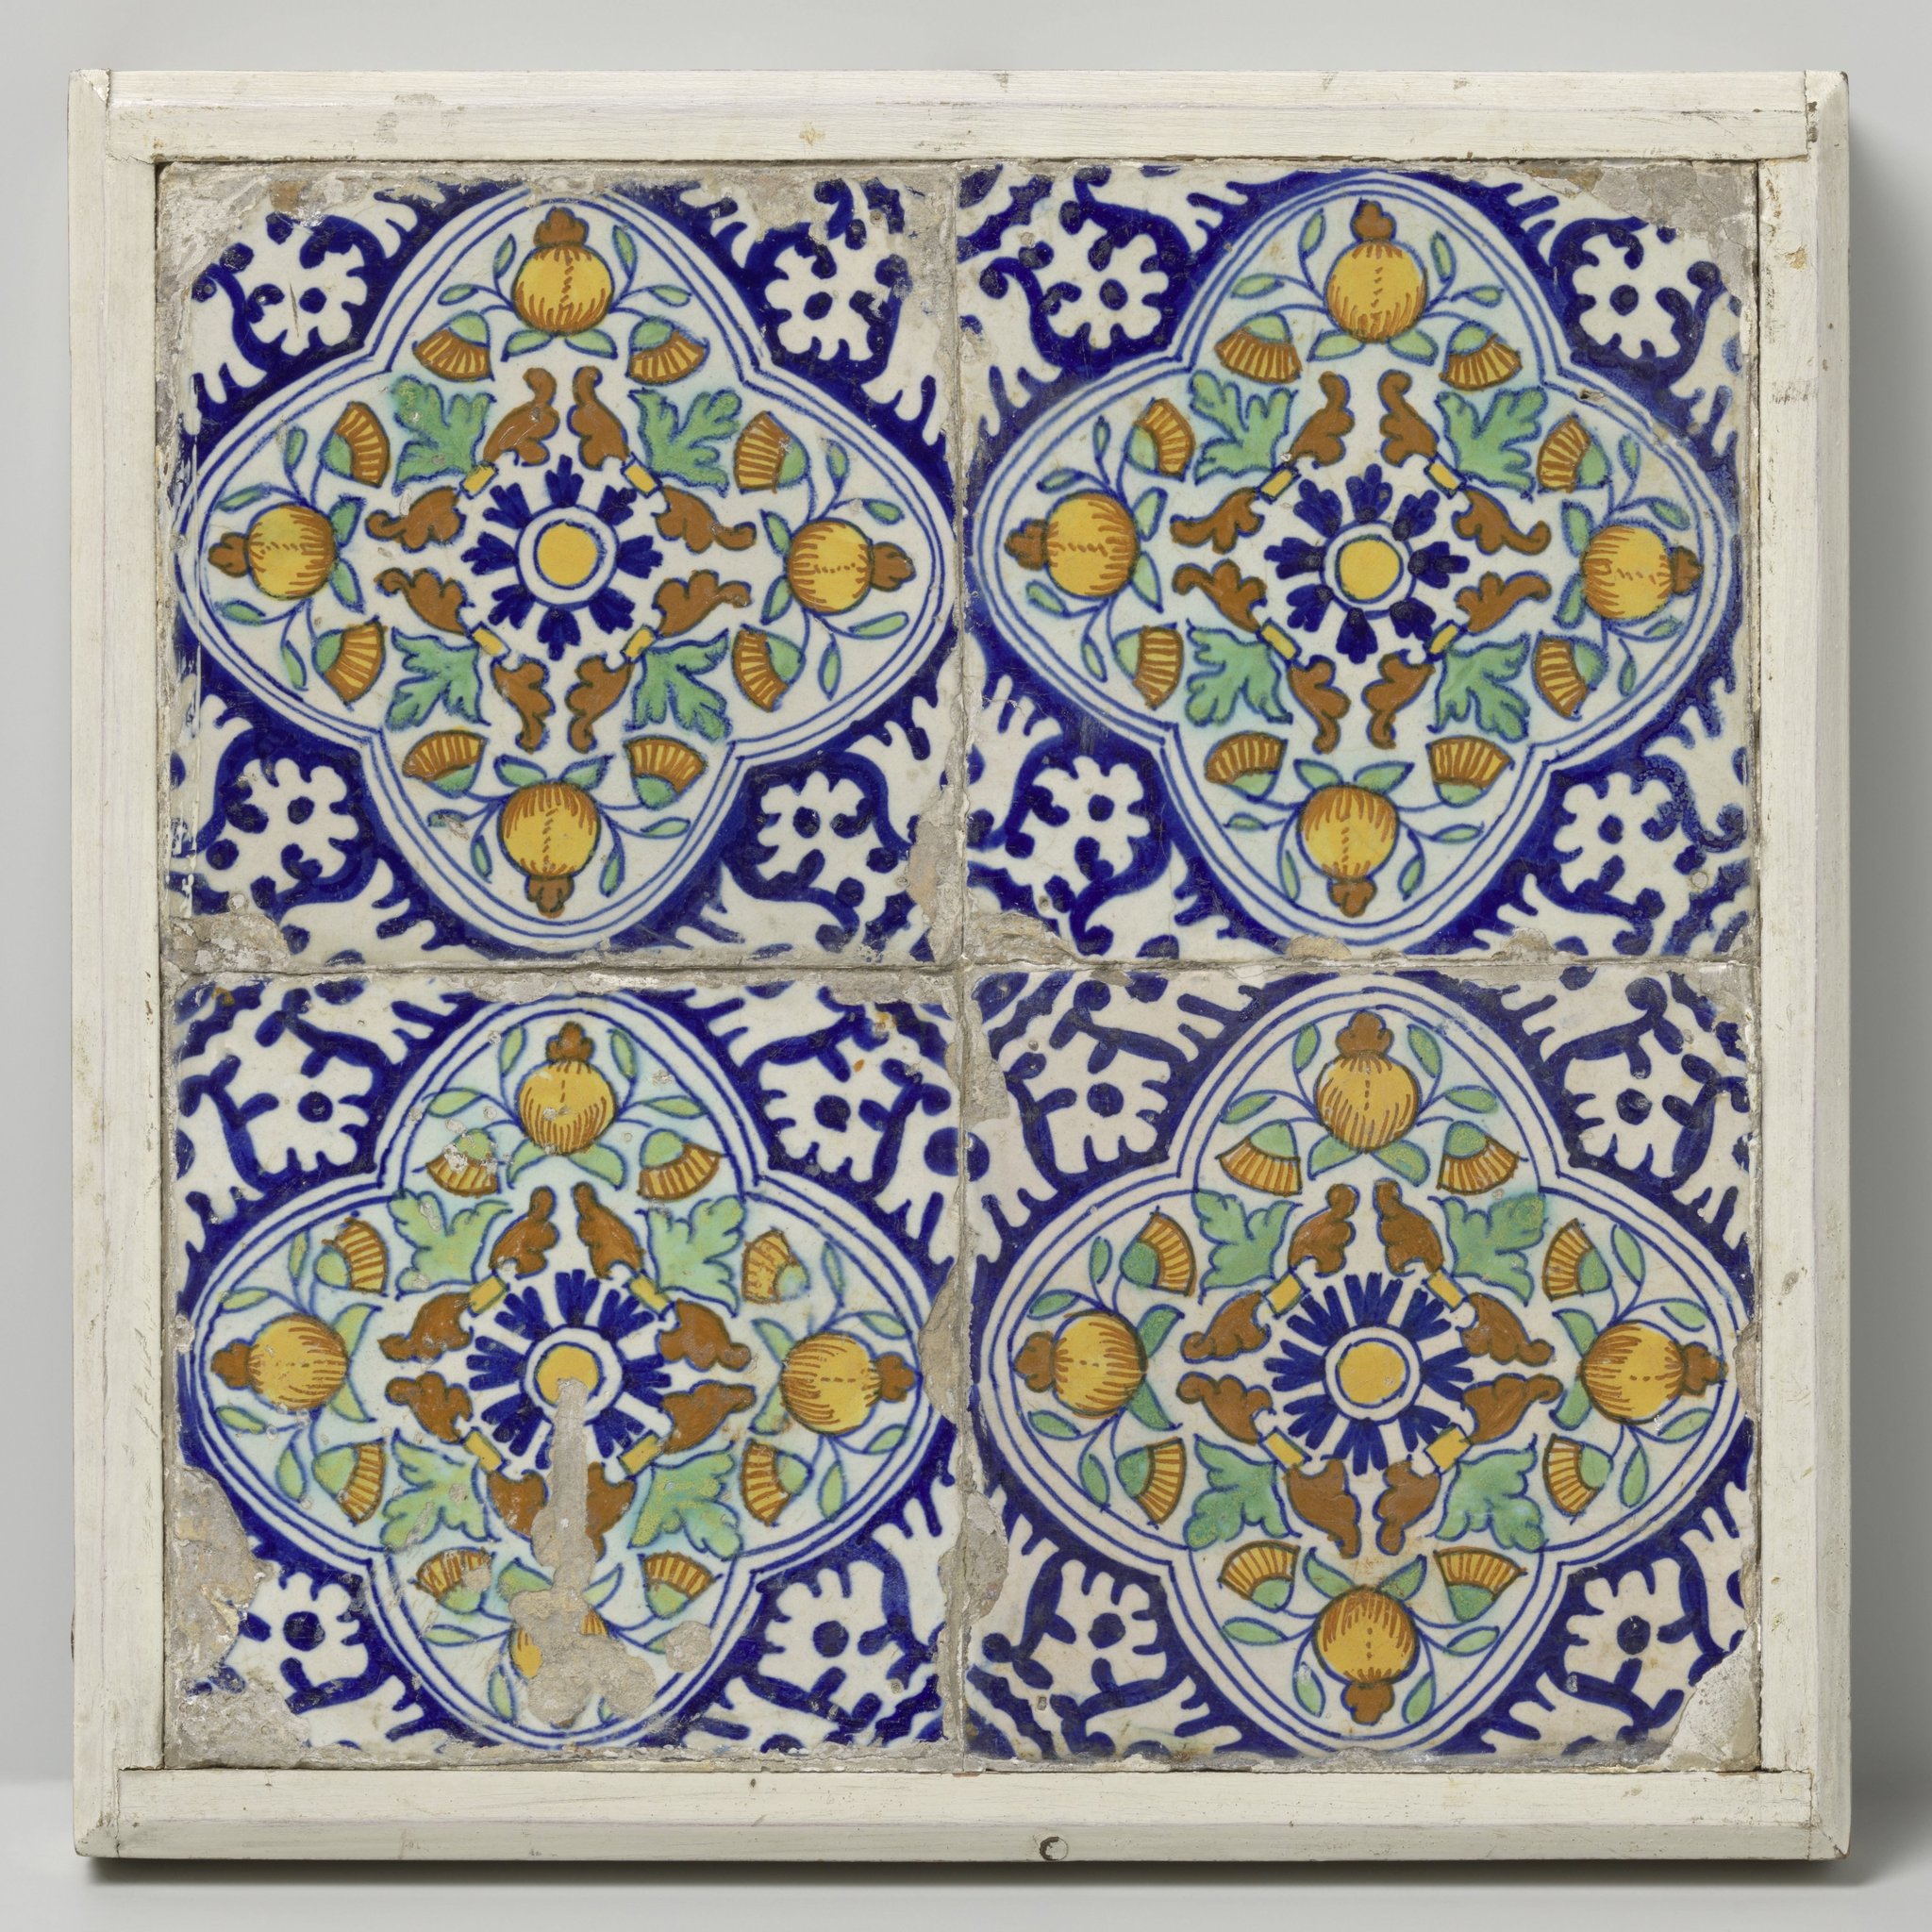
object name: tile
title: Veld van vier pompadourtegels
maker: Anonymous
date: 1615-1635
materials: earthenware, glaze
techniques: maiolica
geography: netherlands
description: Veld van 4 pompadourtegels (2 x 2) elk met een veelkleurig (blauw, geel, rood-oranje en groen) geschilderde rozet omgeven door granaatappels binnen een vierpas omlijsting. In de hoeken, vultechniek ornament.